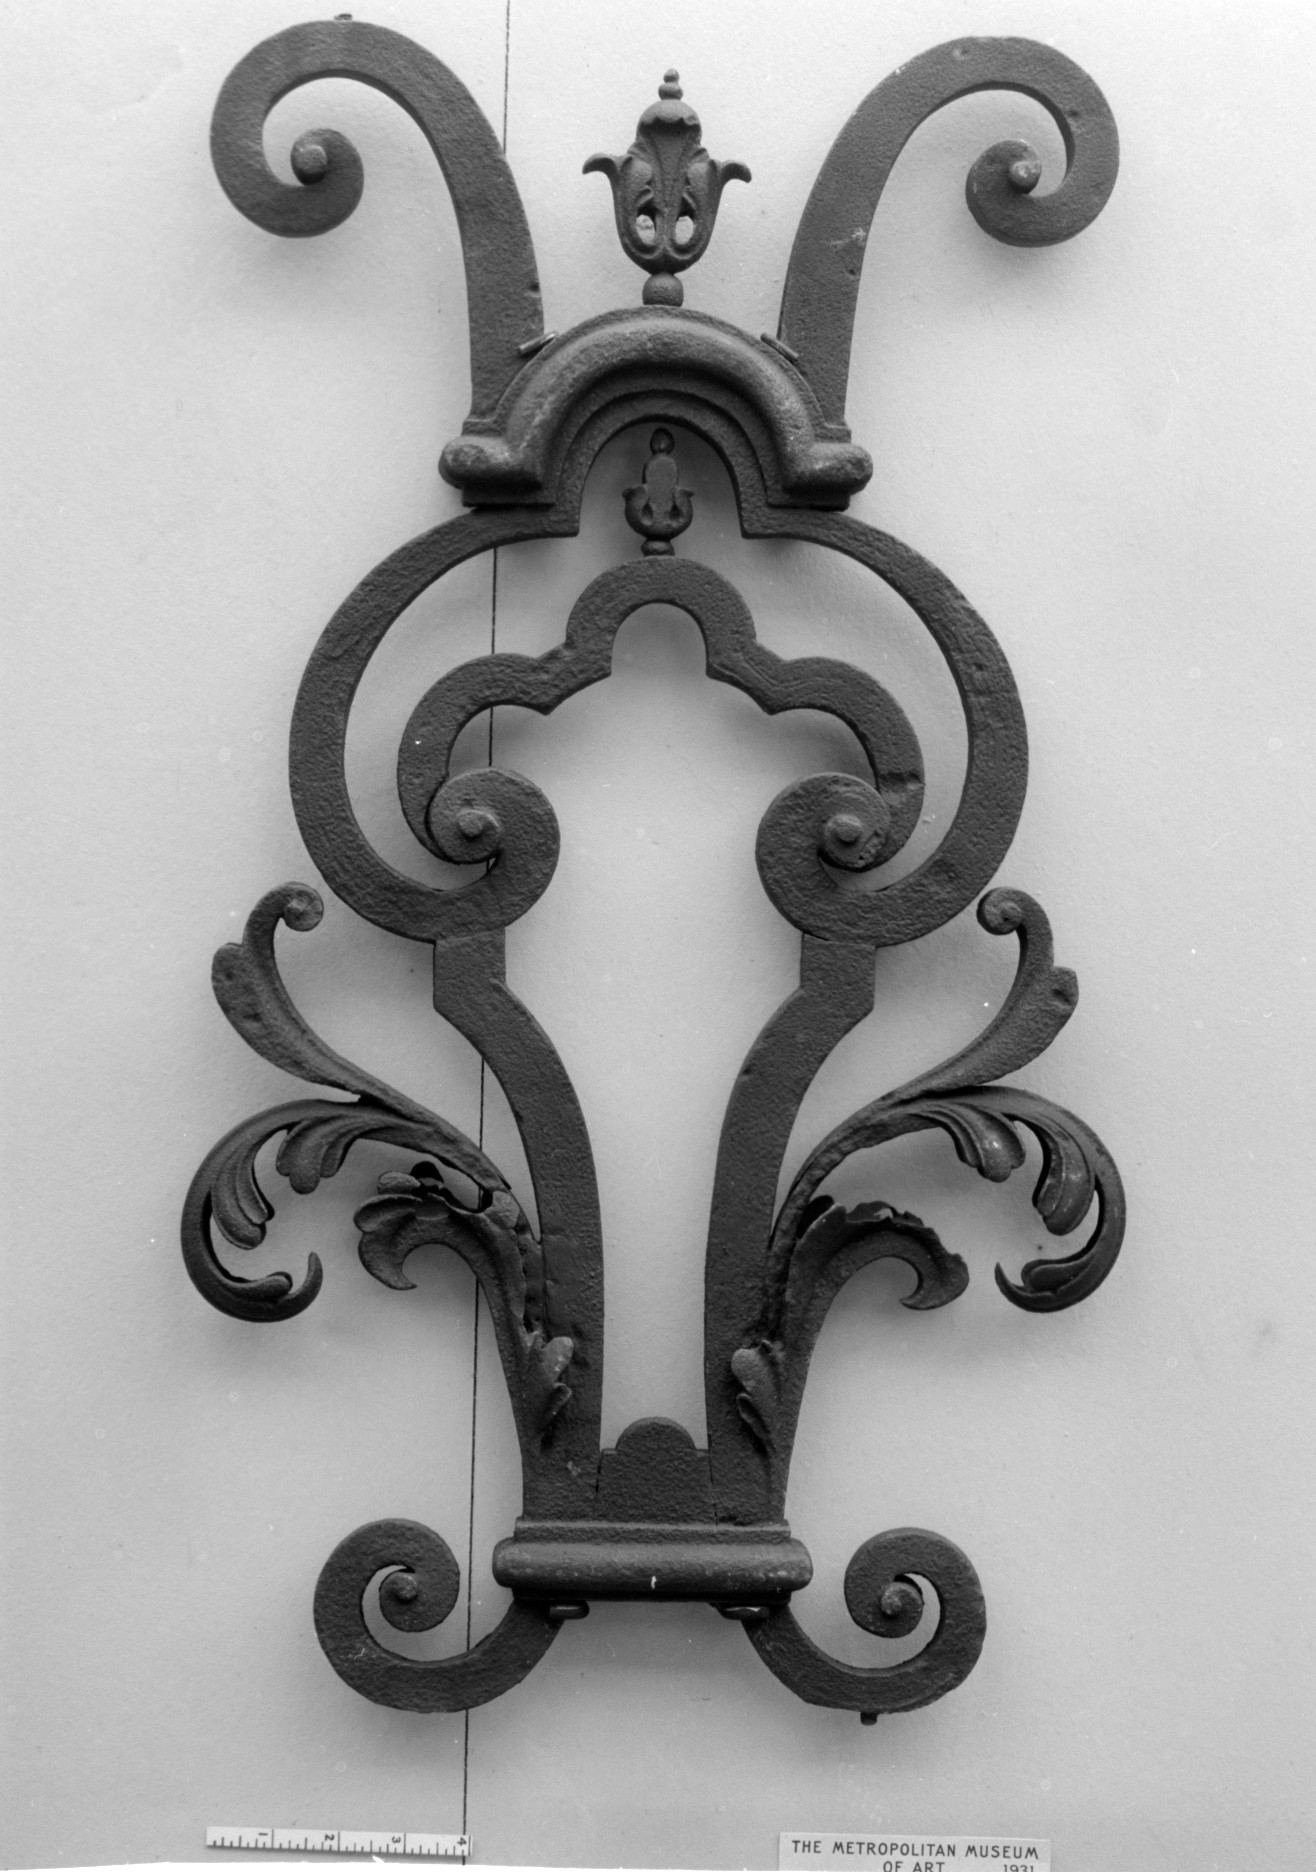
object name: baluster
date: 1715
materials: iron